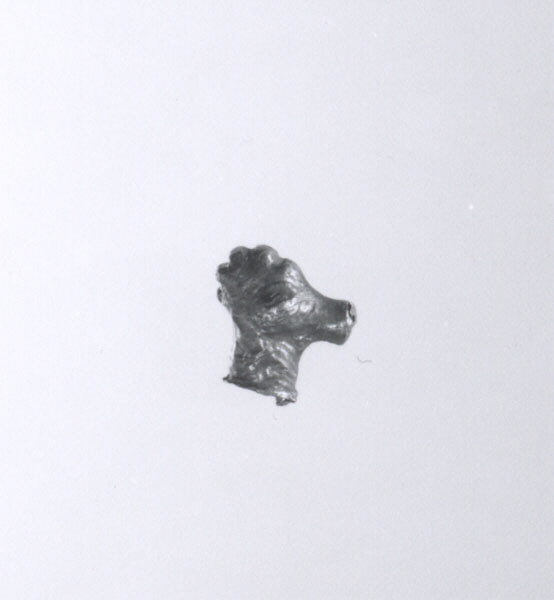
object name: terminal or bead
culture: iranian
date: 1000-1 BCE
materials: gold foil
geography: iran